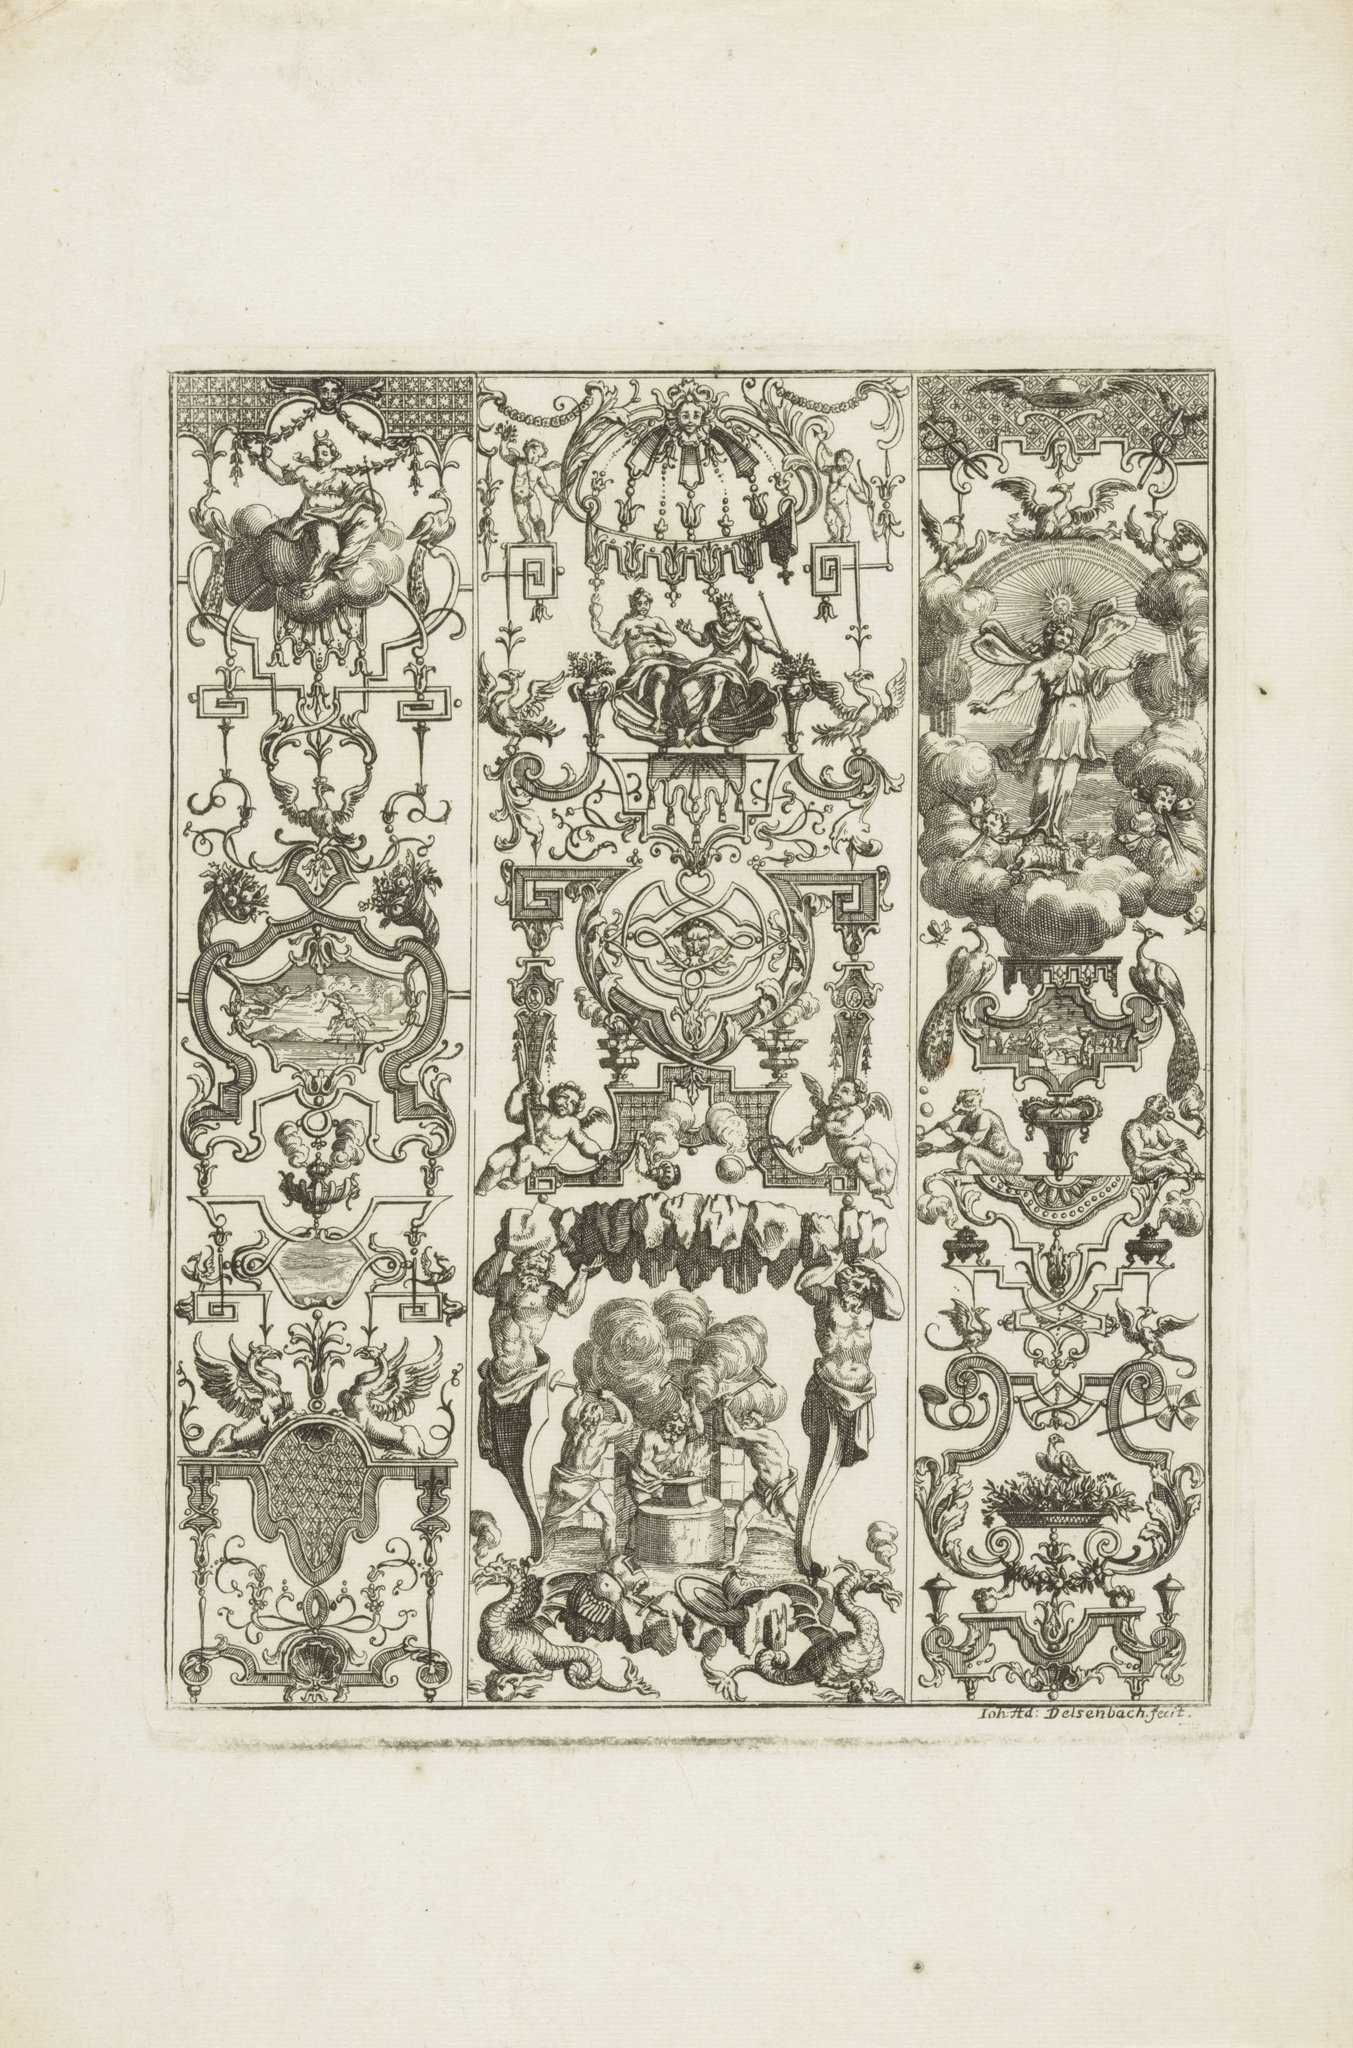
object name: ornament print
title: Grotesken met Diana en gevleugelde vrouwfiguur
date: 1700-1725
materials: paper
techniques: etching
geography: nuremberg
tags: ornament ~ grotesque, (story of) diana (artemis), abstract ideas and concepts (+ clothed with wings)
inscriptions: collector's mark: Lugt 2233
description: Drie pilasters met grotesken en diverse mythische figuren en scènes.